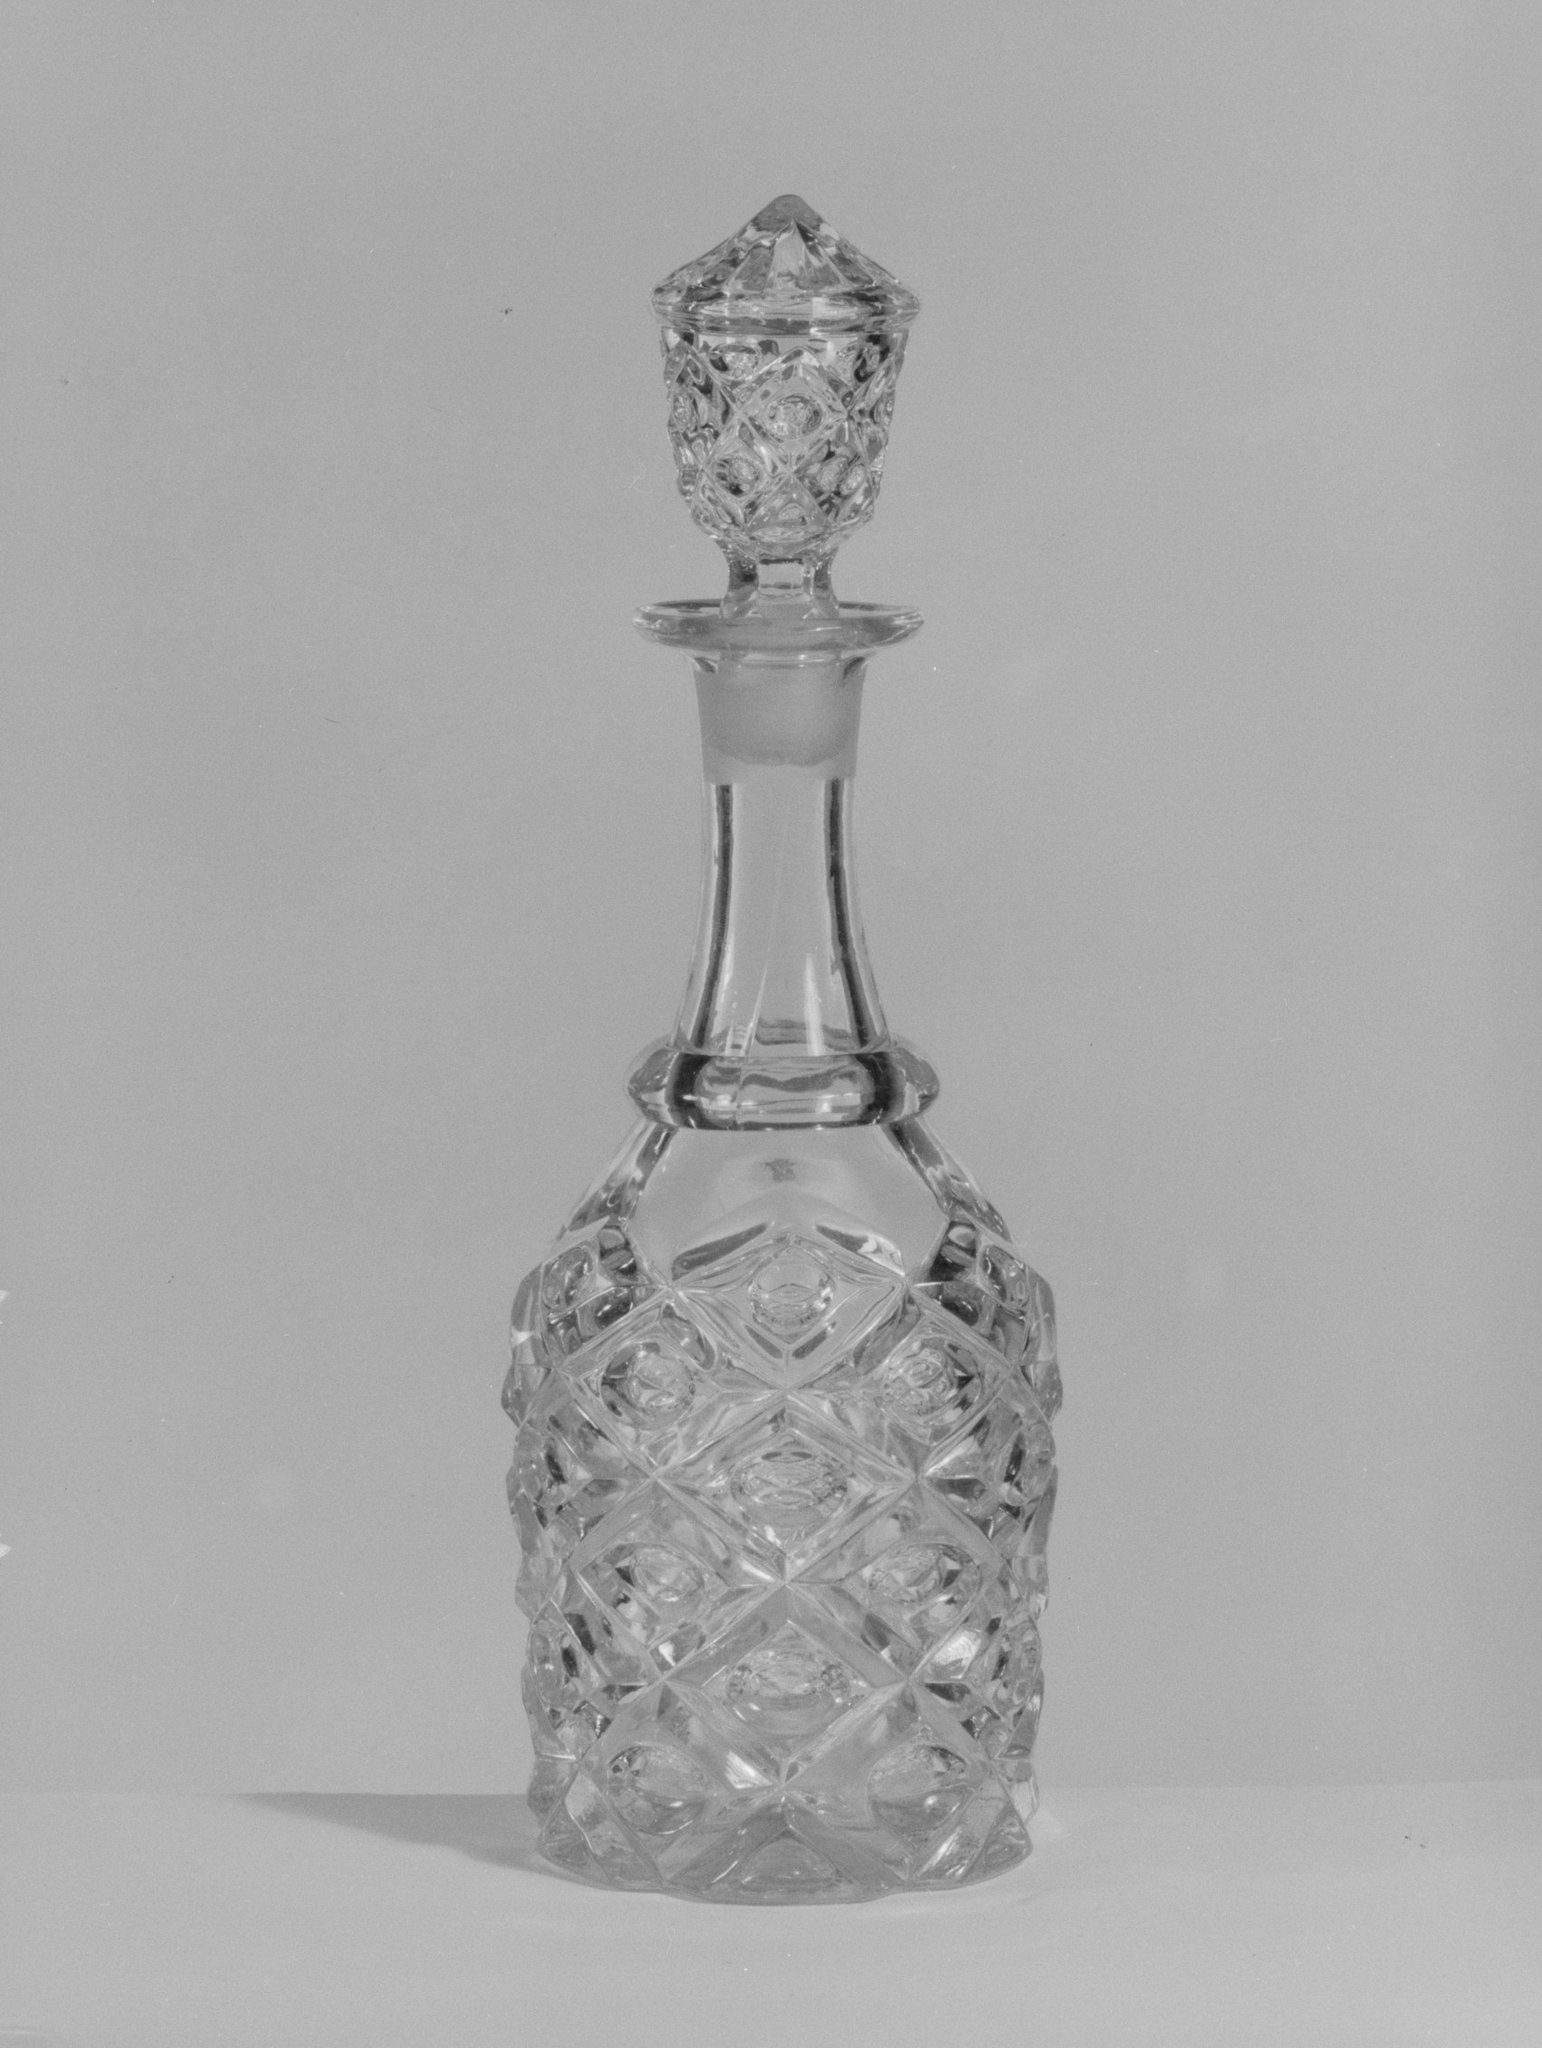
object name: pint decanter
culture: american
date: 1850-1870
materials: diamond, glass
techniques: pressed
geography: united states